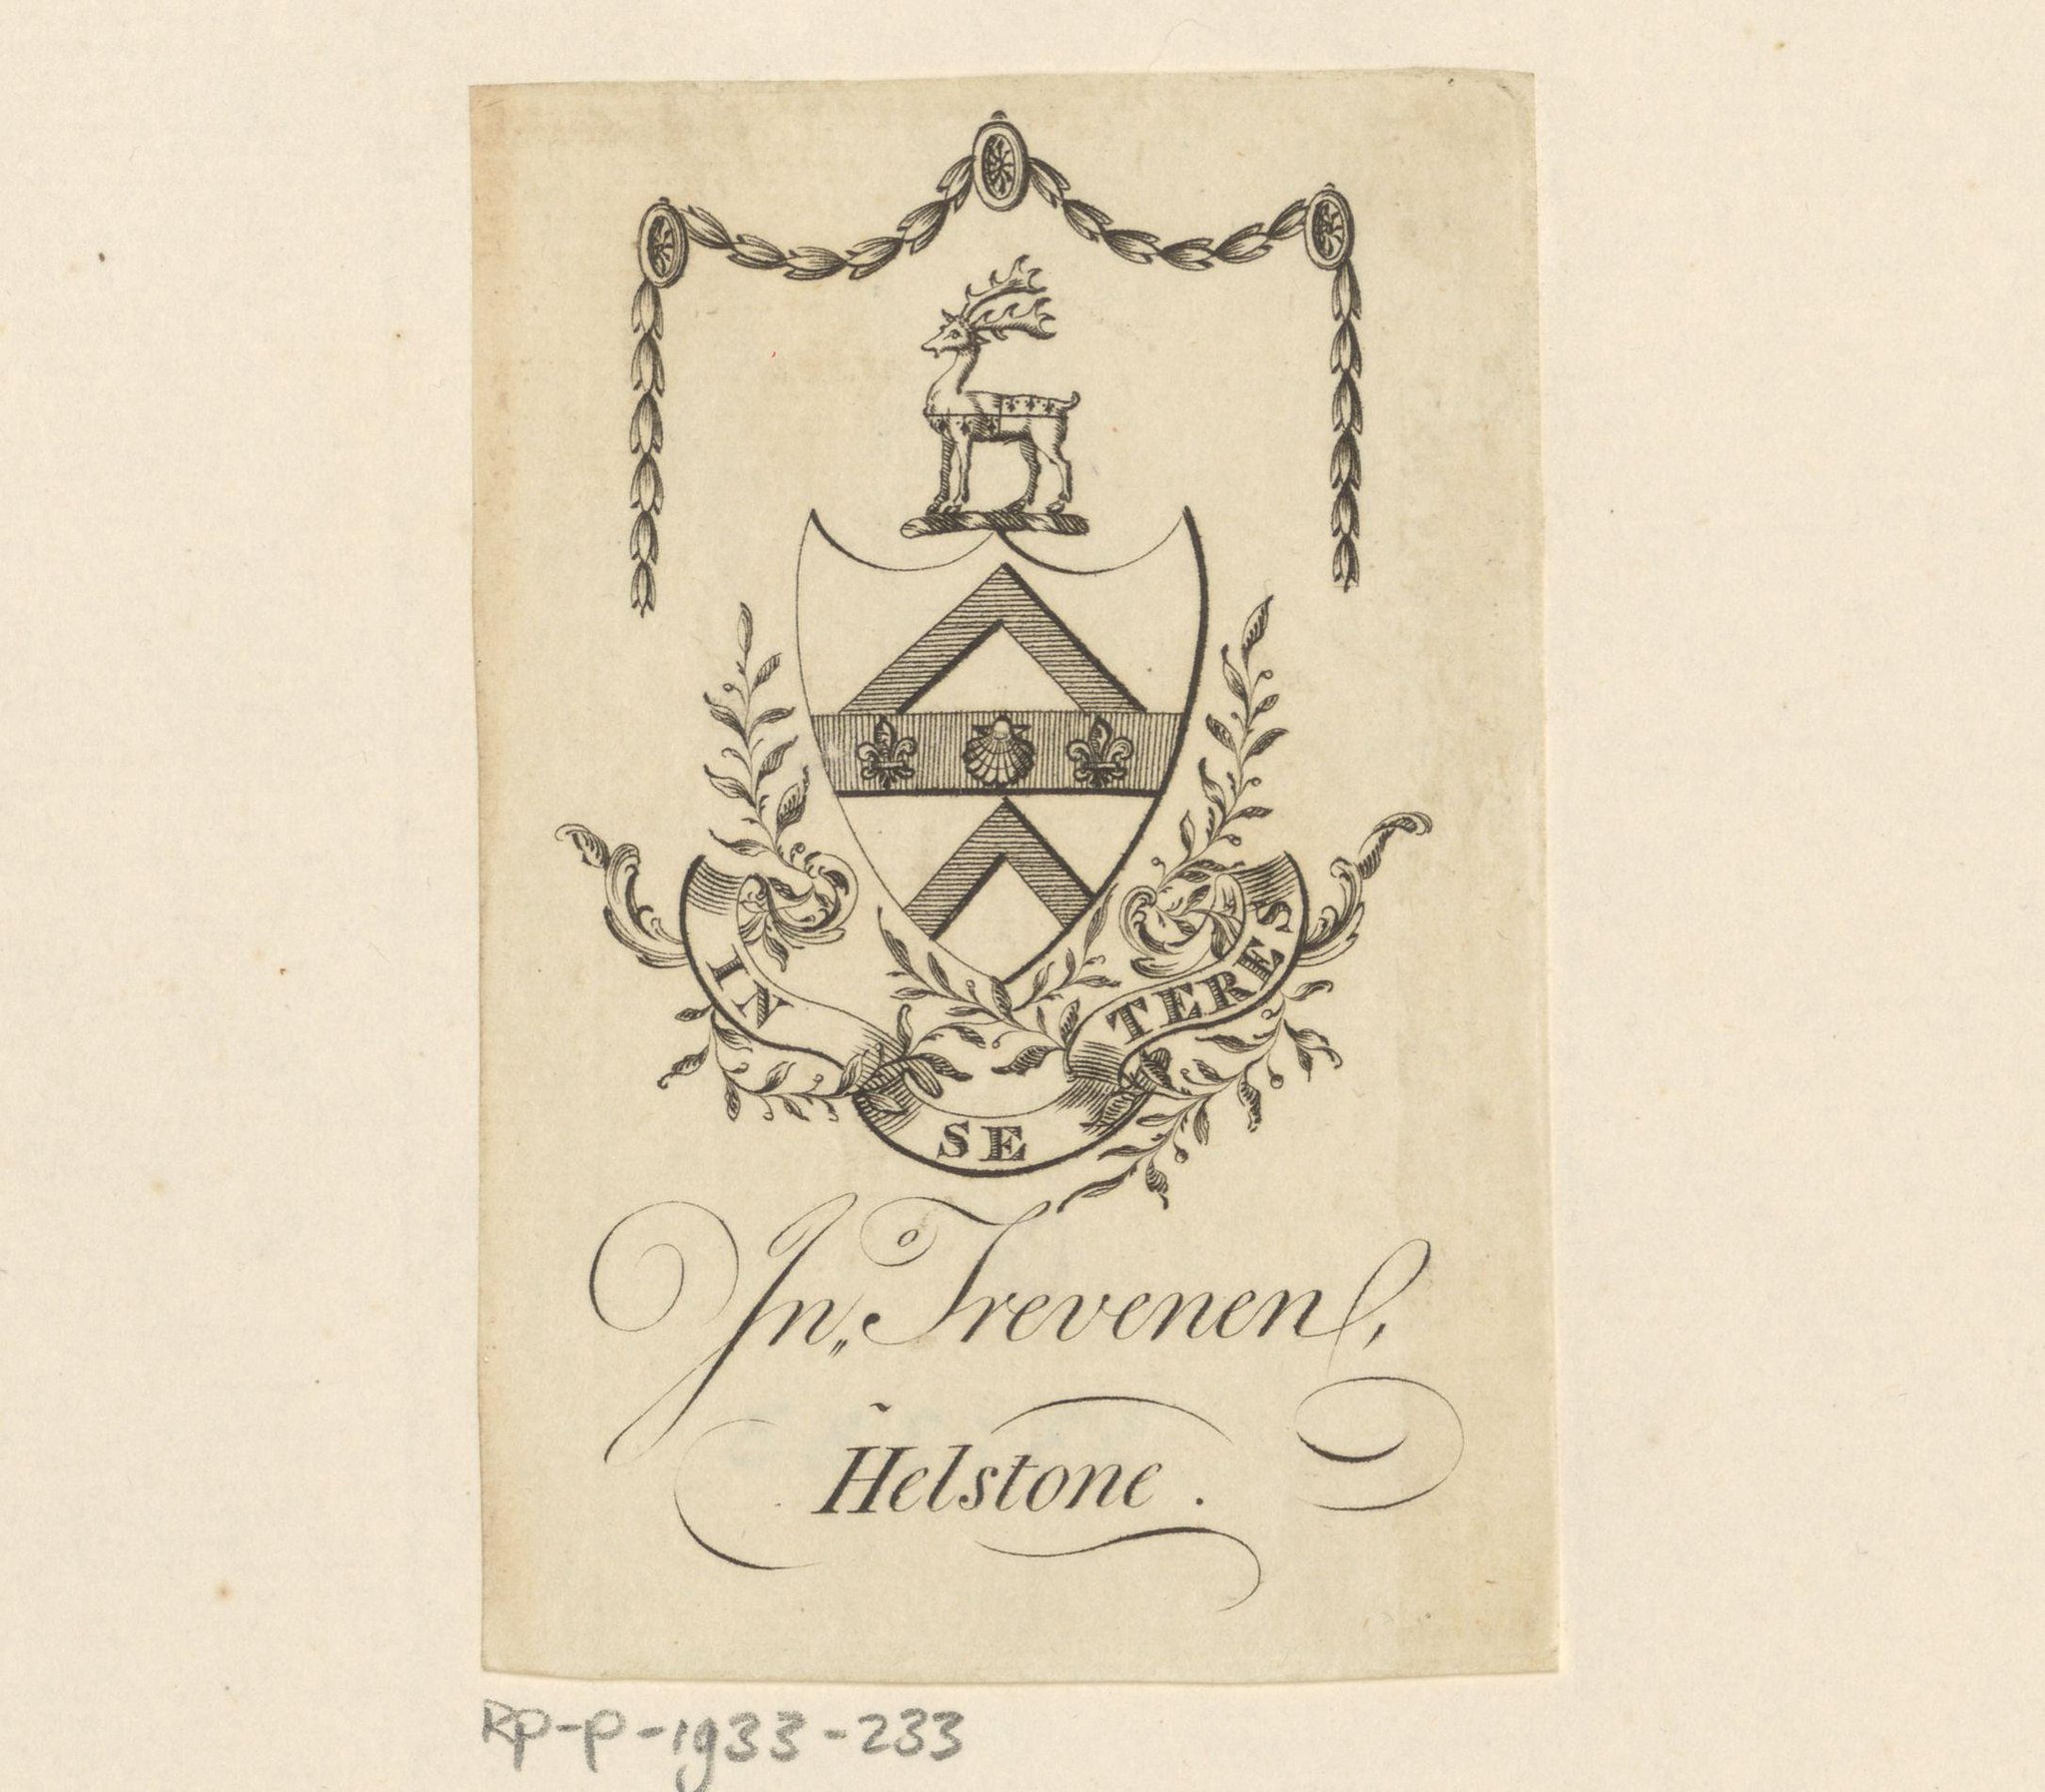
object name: bookplate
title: Ex libris van Jn. Trevenen Helstone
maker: Anonymous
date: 1750-1849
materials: paper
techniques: engraving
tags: armorial bearing, heraldry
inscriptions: collector's mark: Lugt 2760